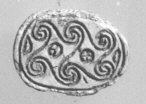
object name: stamp seal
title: Scarab seal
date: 1786-1650 BCE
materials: bone, stone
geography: levant